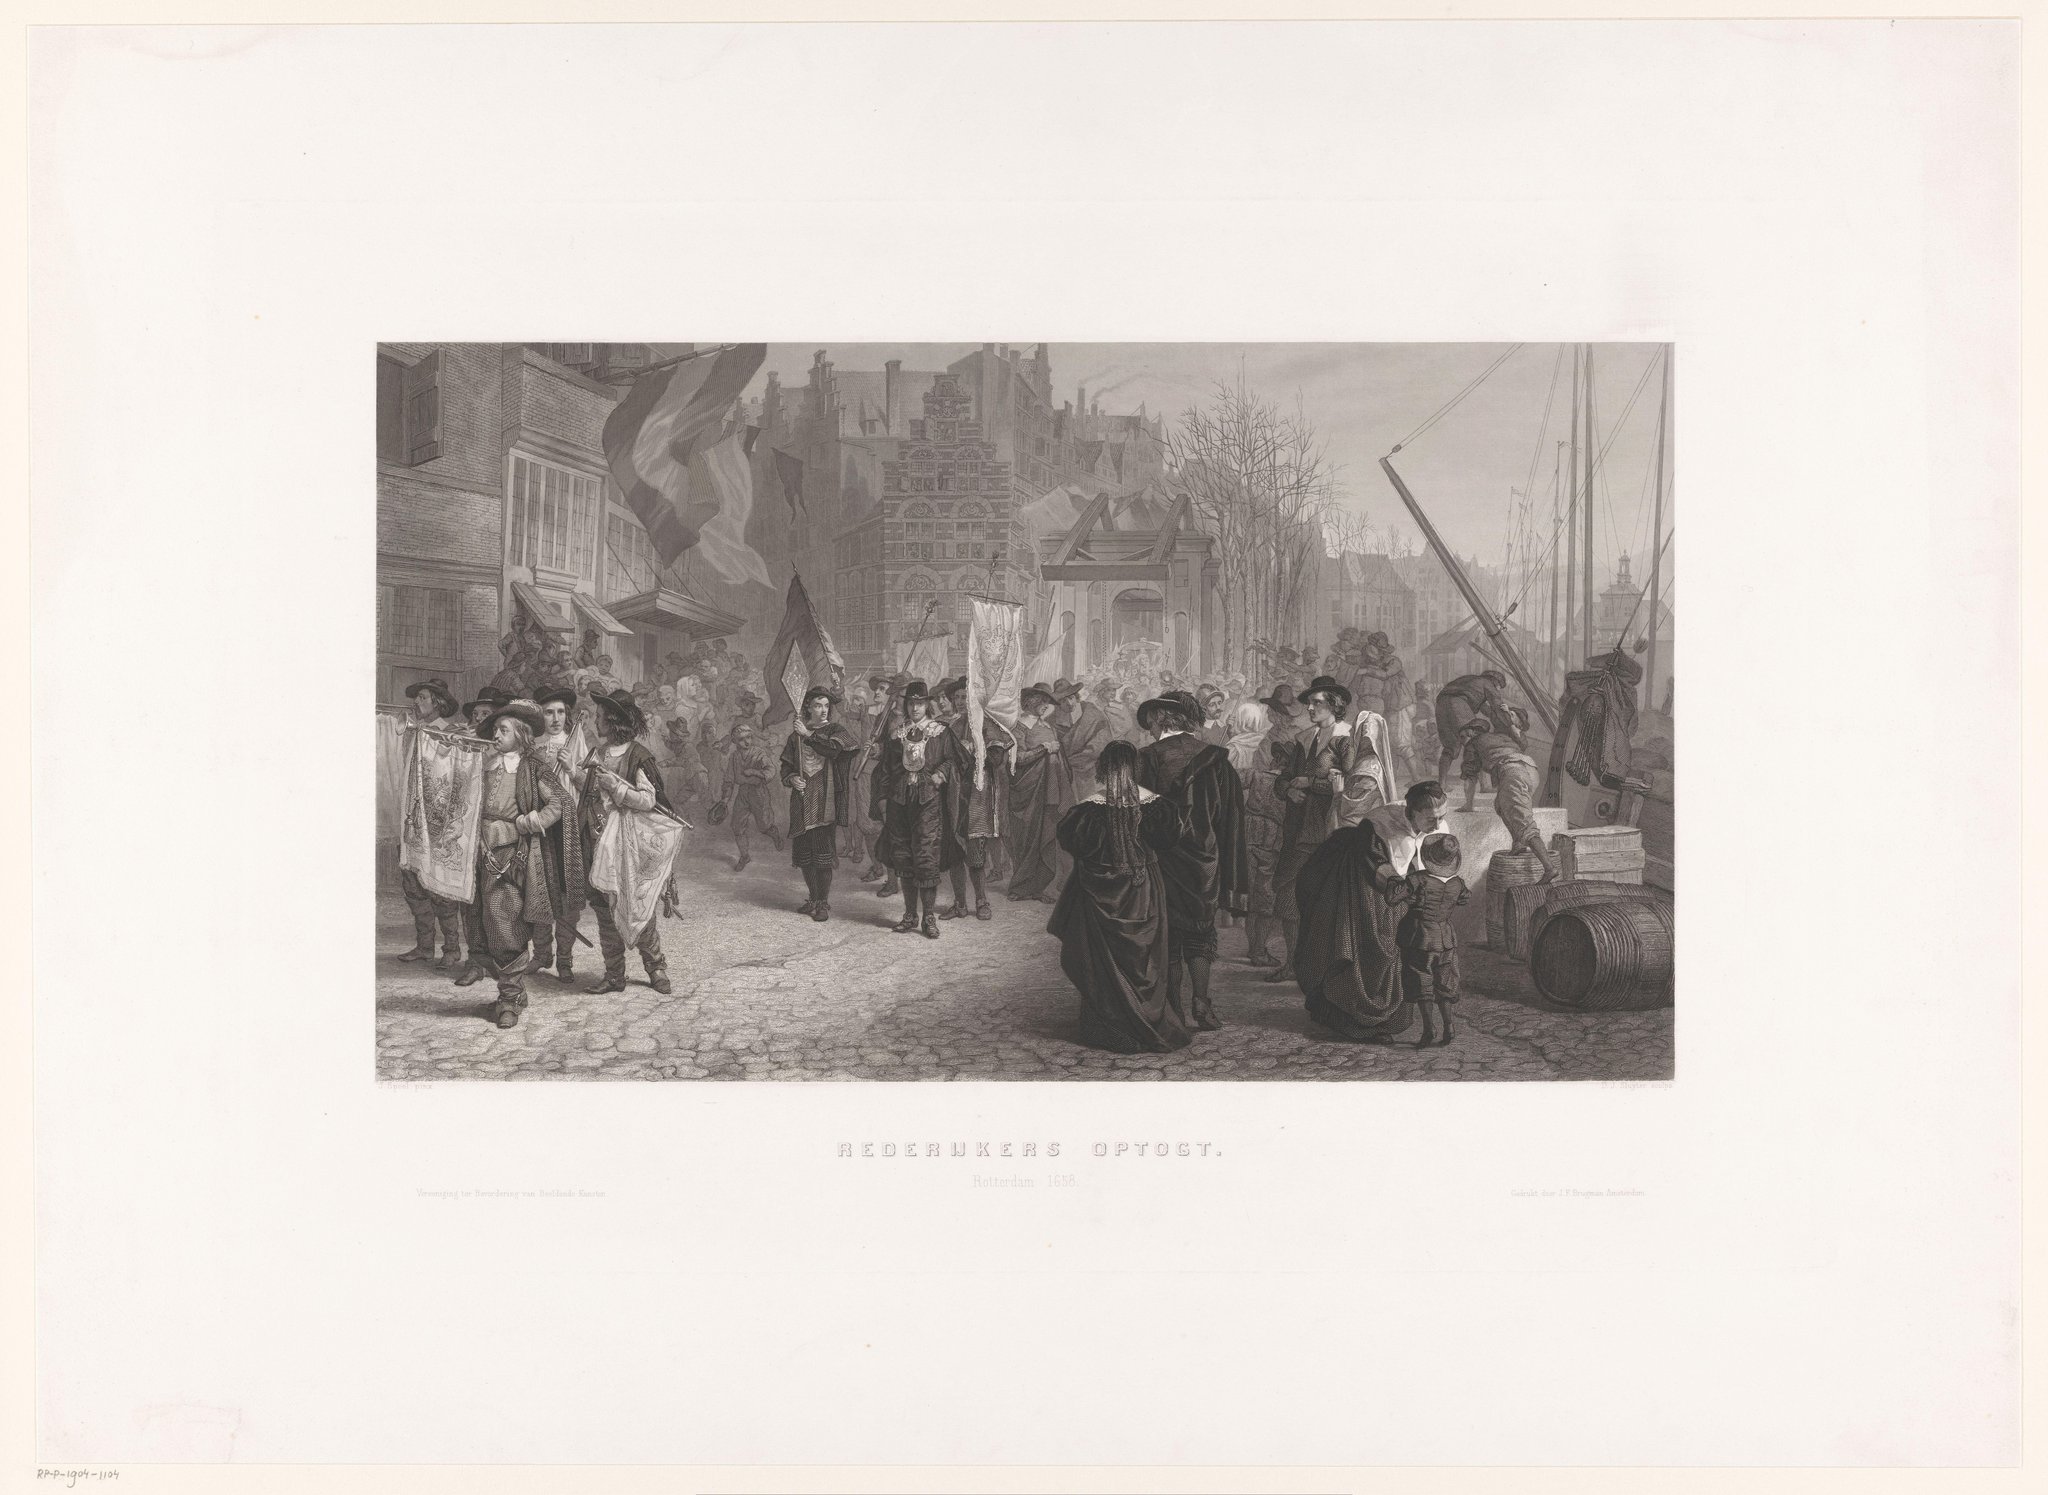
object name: print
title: Rederijkersoptocht te Rotterdam, 1658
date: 1868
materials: paper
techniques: engraving, etching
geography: amsterdam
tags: pageant of a guild, chamber of rhetoric (dutch: 'rederijkerskamer'), rotterdam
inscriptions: collector's mark: Lugt 2228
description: Rederijkersoptocht te Rotterdam, 1658. Optocht voorafgegaan door vier trompetters met het stadswapen, gevolgd door de rederijkers met hun banieren. De stoet trekt over een brug en langs huizen, rechts een kade met boten.